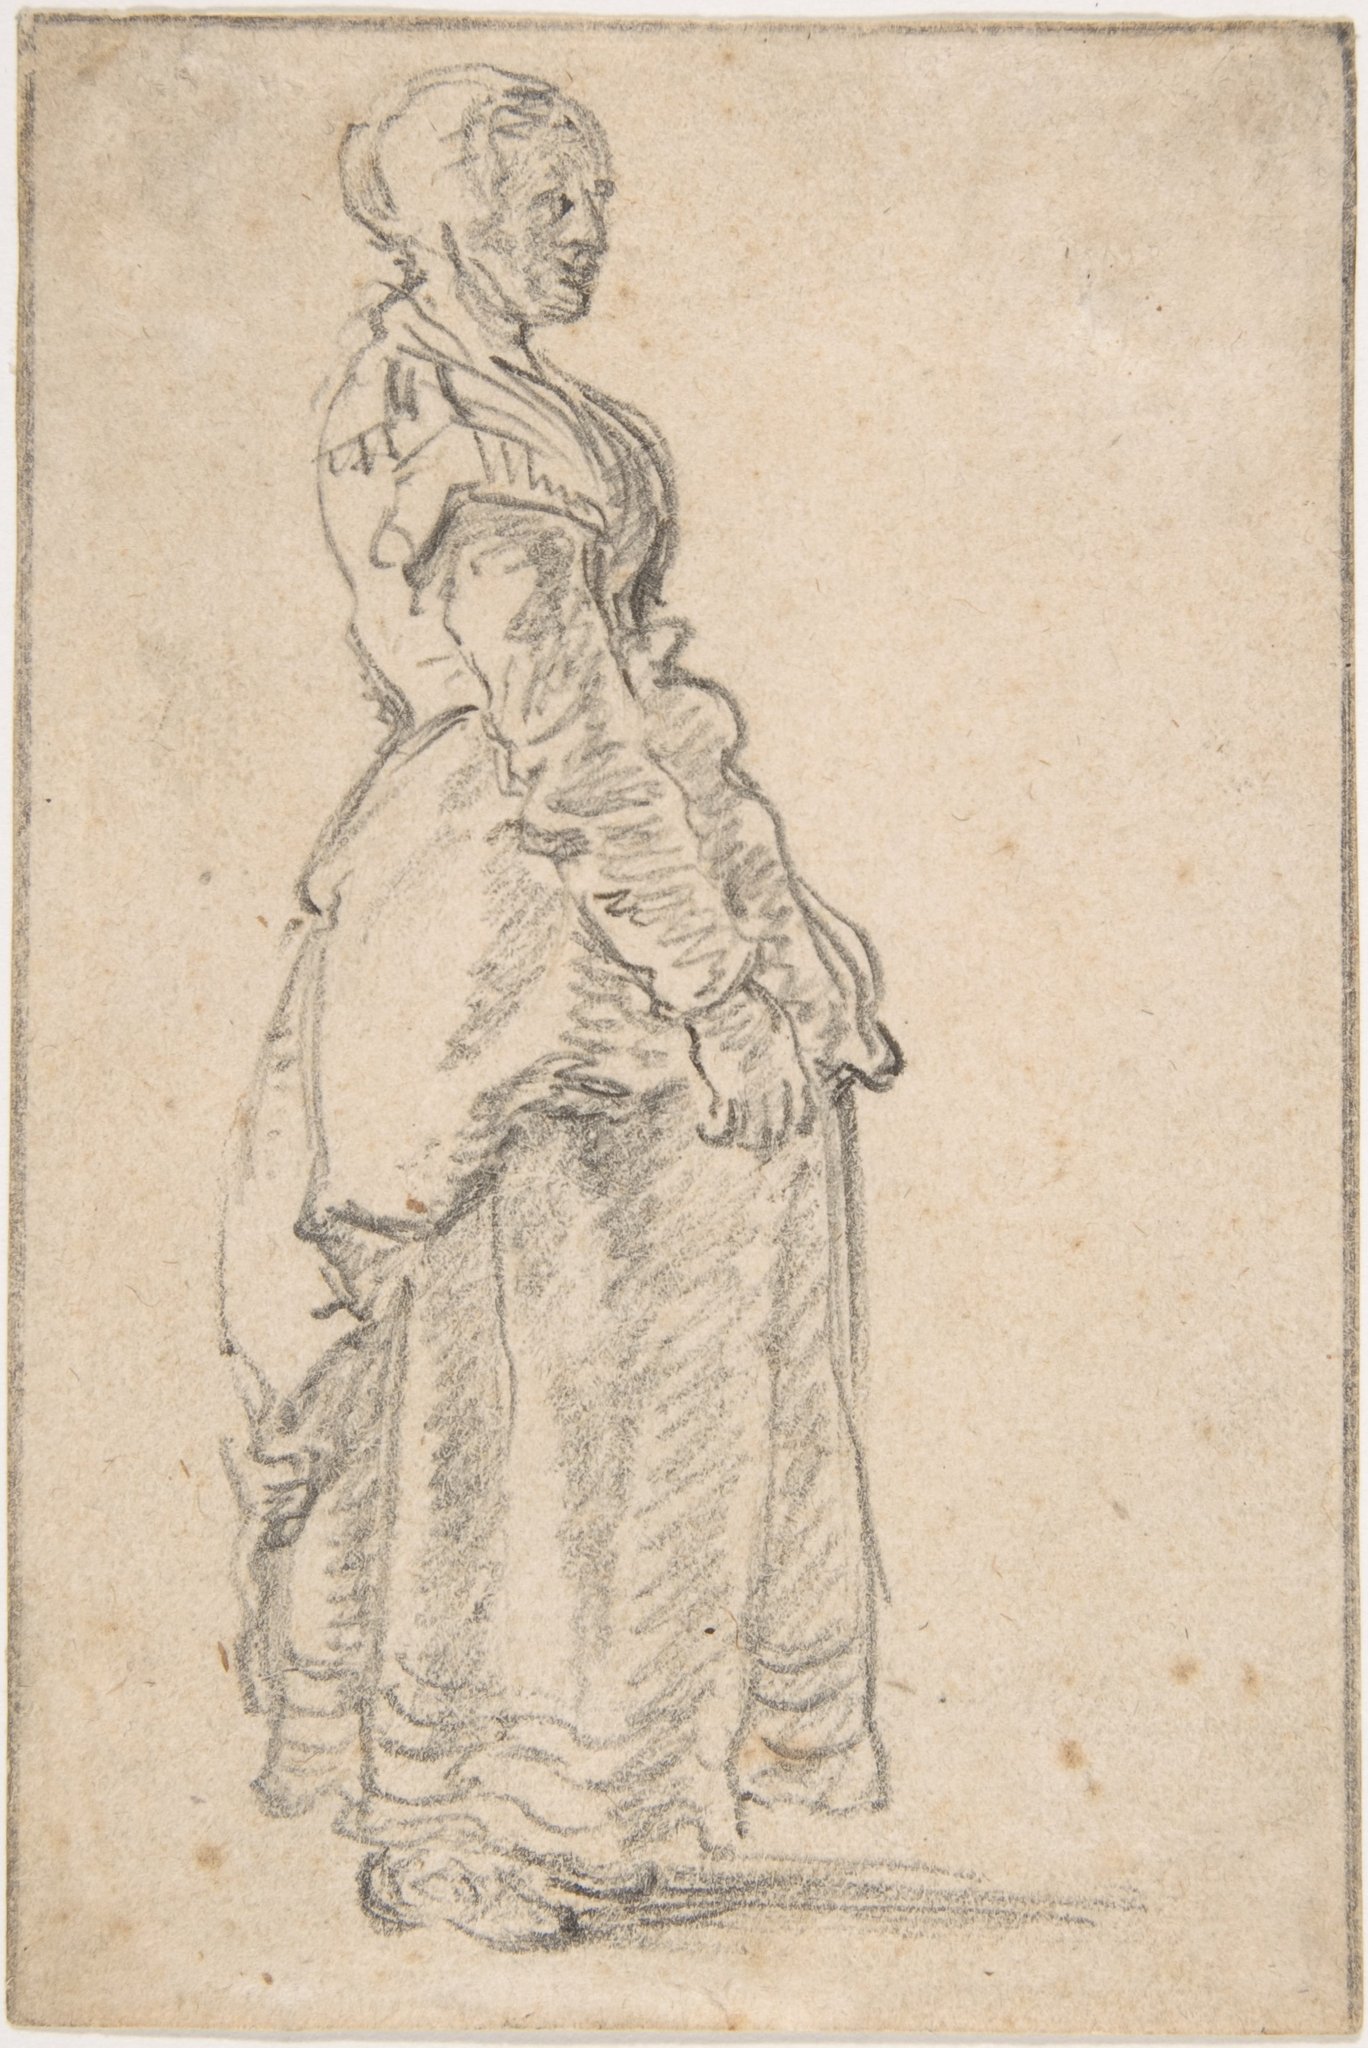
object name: drawing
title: Standing Woman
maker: jan van goyen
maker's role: artist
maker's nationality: dutch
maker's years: 1596-1656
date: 1601-1666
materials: chalk, lead, paper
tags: women